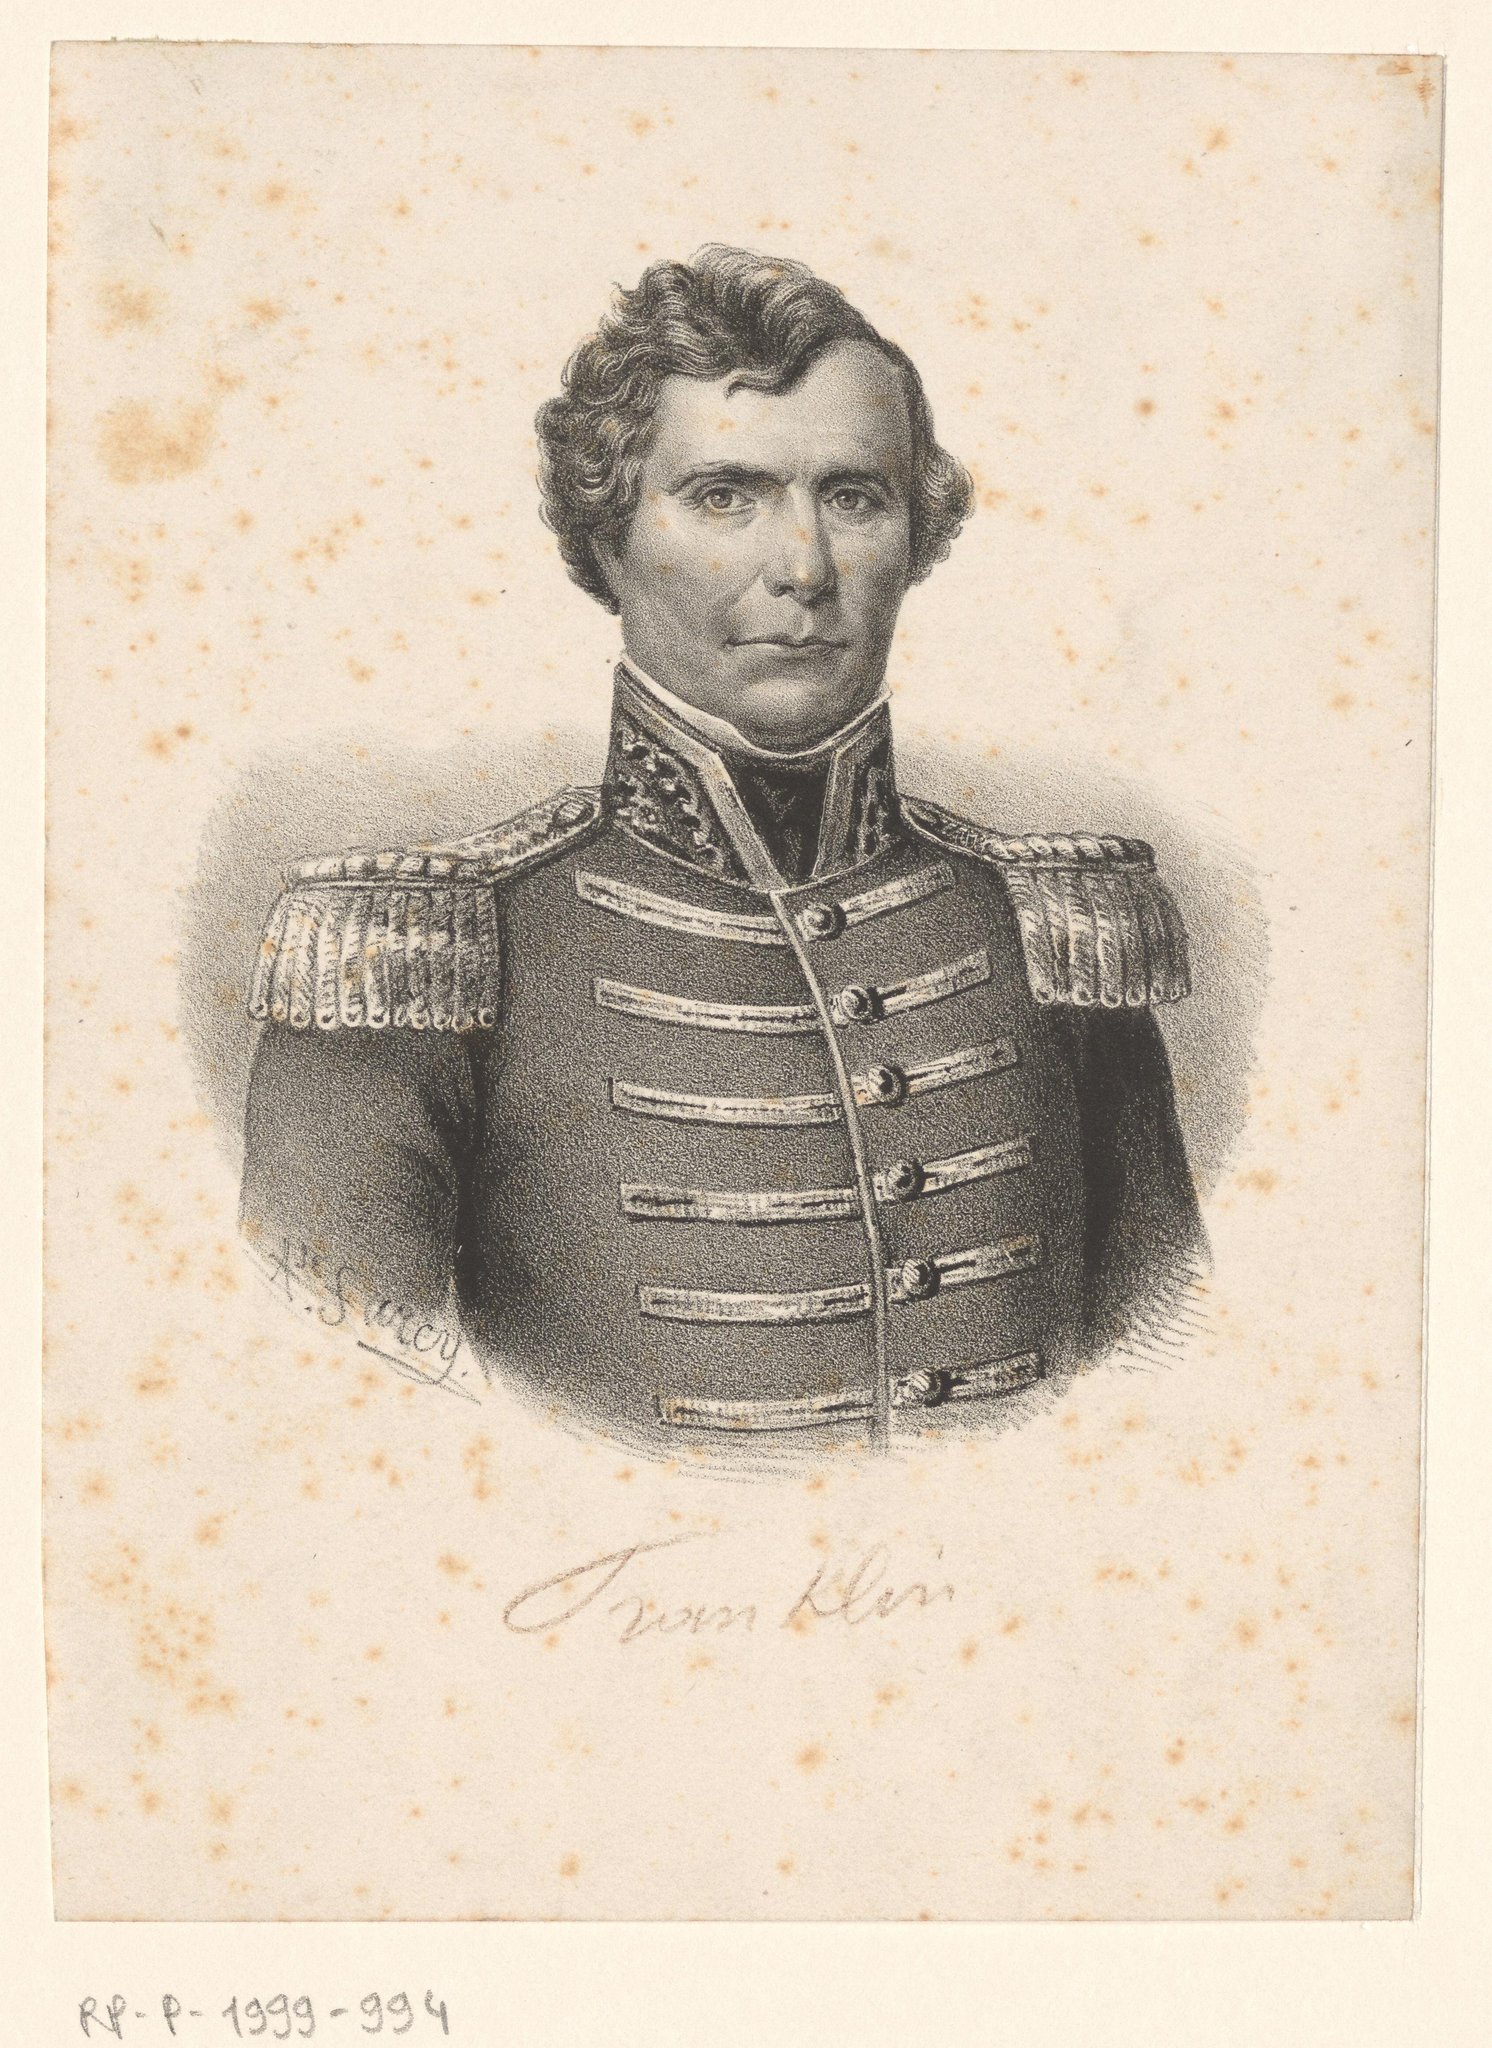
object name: print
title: Portret van Franklin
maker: alphonse farcy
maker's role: print maker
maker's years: 1817-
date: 1849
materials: paper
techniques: lithograph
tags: anonymous historical person portrayed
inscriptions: collector's mark: Lugt 2228, collector's mark: Lugt 2760, inscription: ‘Franklin’